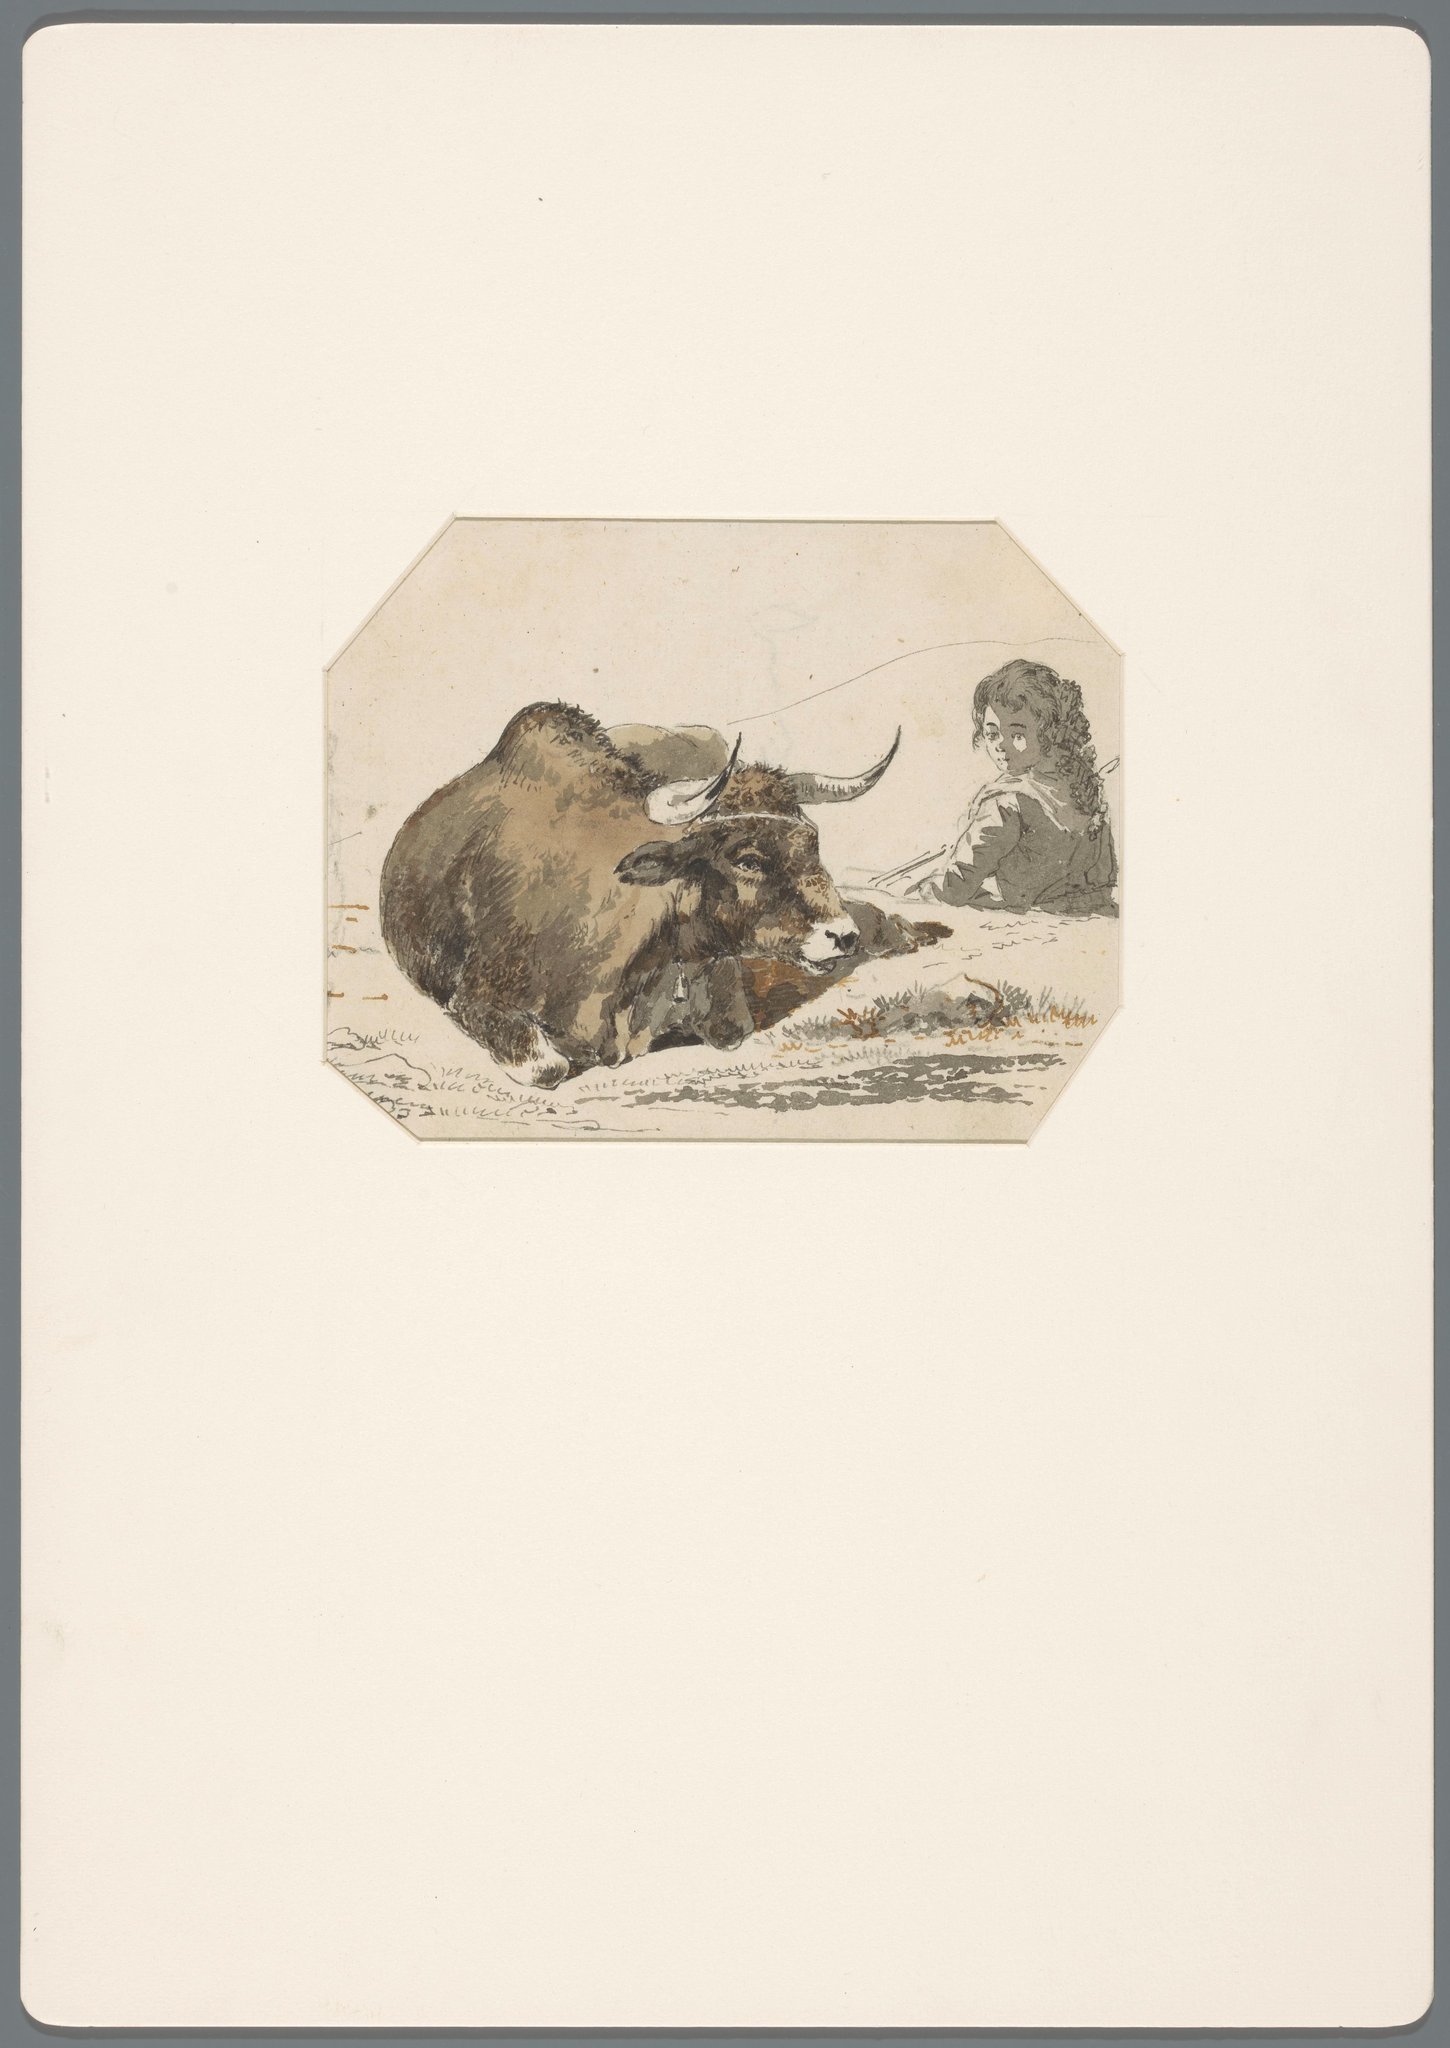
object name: drawing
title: Herdersmeisje zittend achter een liggend rund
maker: david alphonse de sandoz-rollin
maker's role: draughtsman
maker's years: 1740-1809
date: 1750-1809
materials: chalk, ink, paper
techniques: brush, pen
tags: herding, herdsman, herdswoman, shepherd, shepherdess, cowherd, etc., bovine cattle